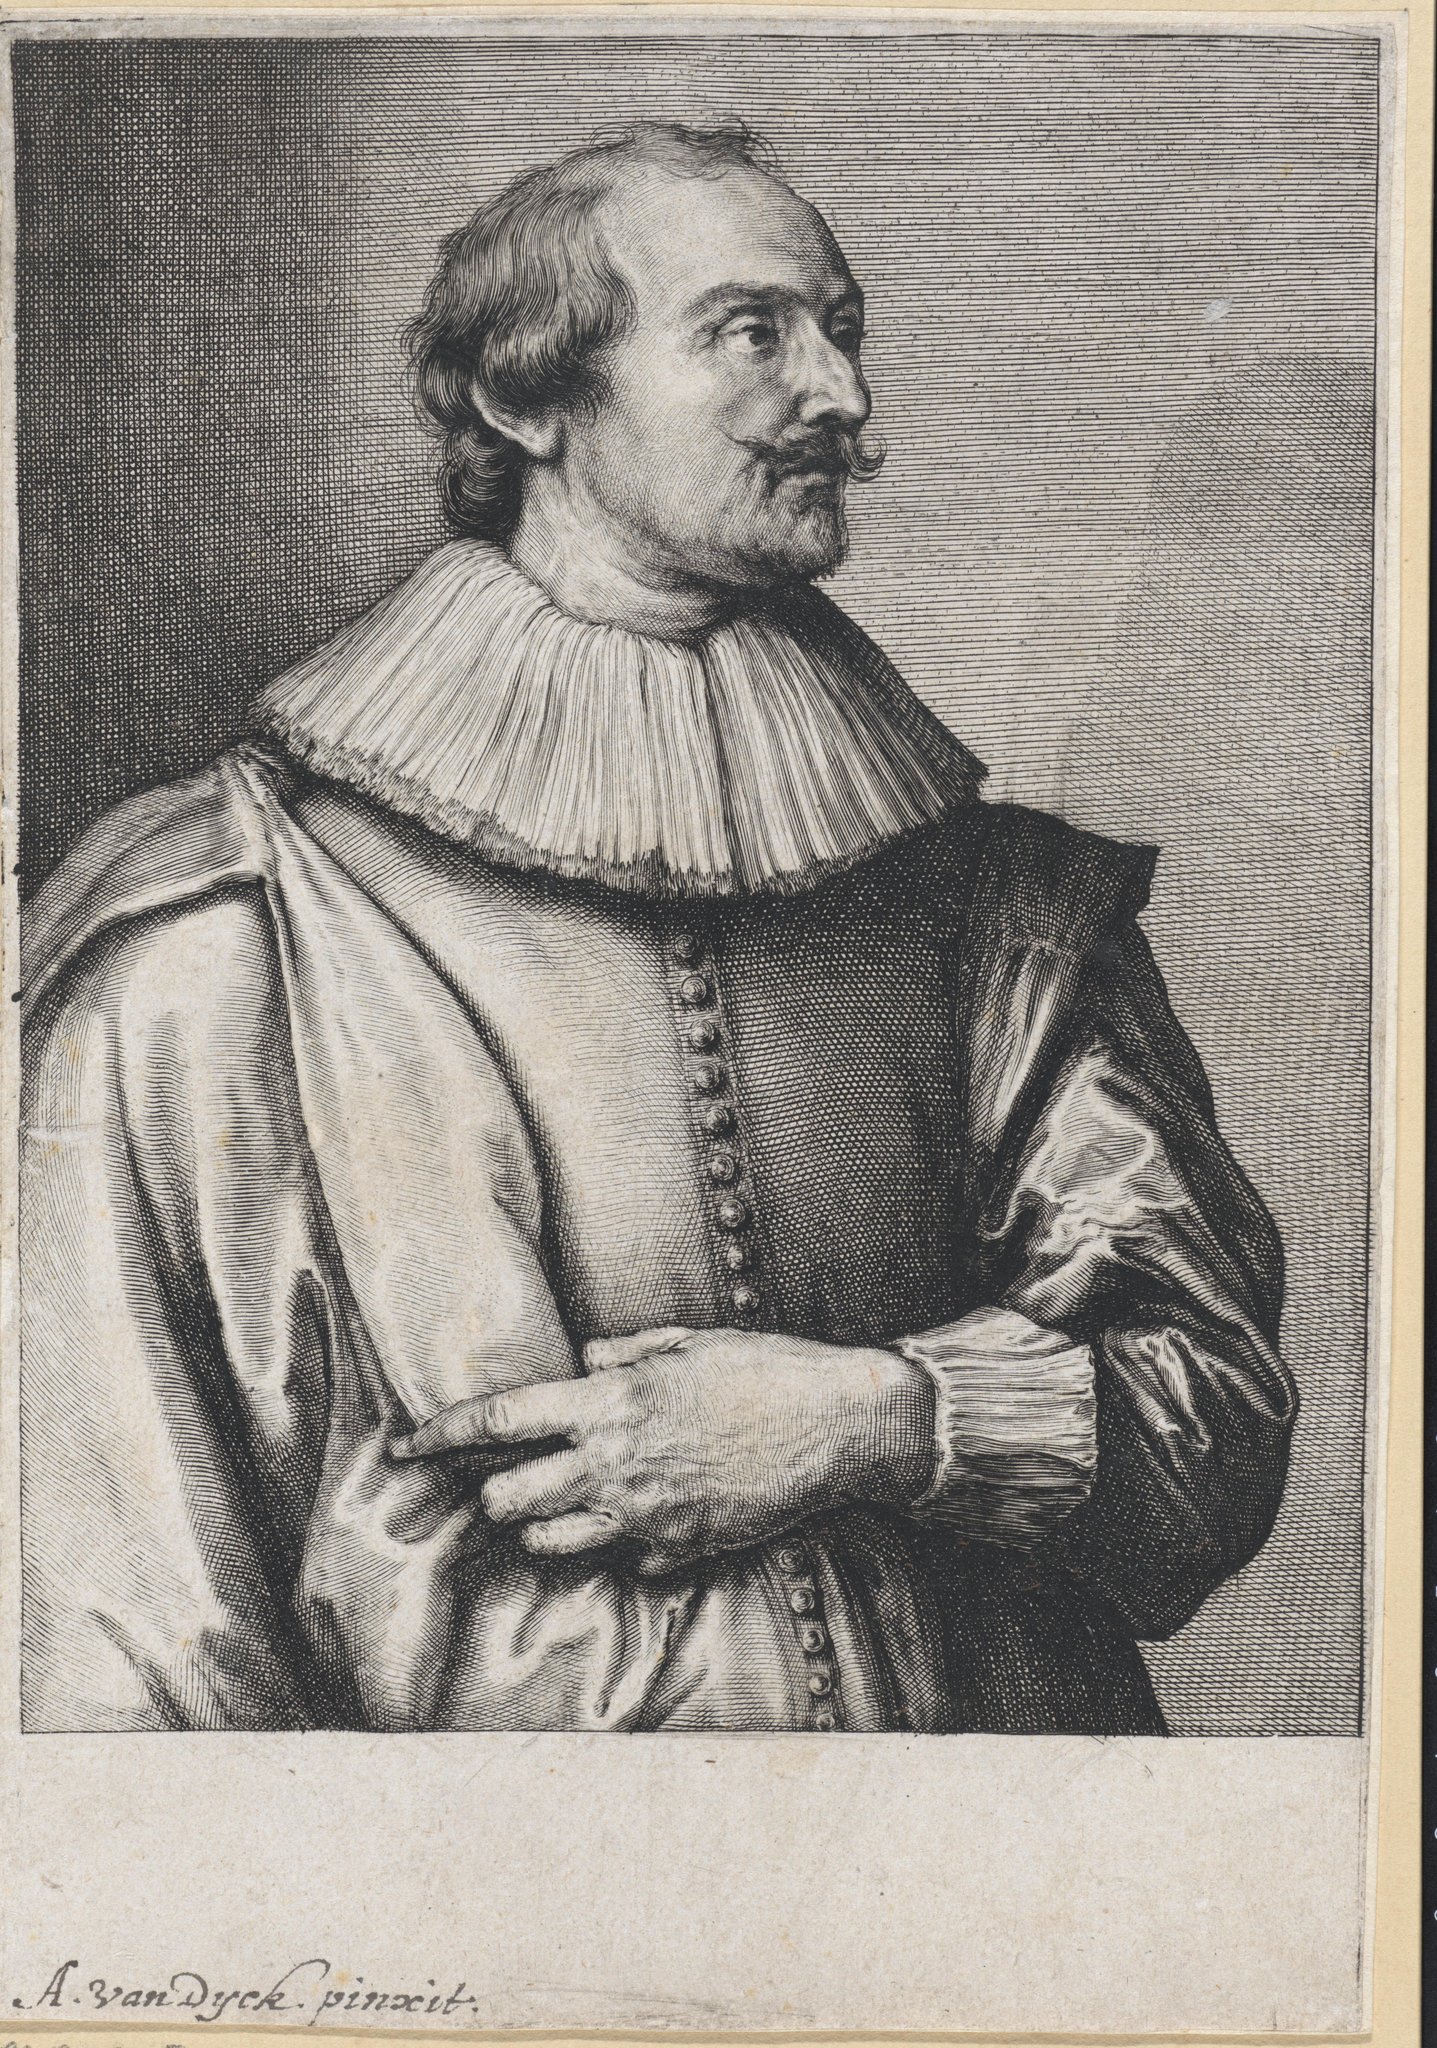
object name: print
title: Portret van Peter Snayers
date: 1614-1648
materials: paper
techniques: engraving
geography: the hague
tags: antwerp, brussels, painter, draughtsman, peeter snayers, portrait, self-portrait of painter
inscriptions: collector's mark: Lugt 240